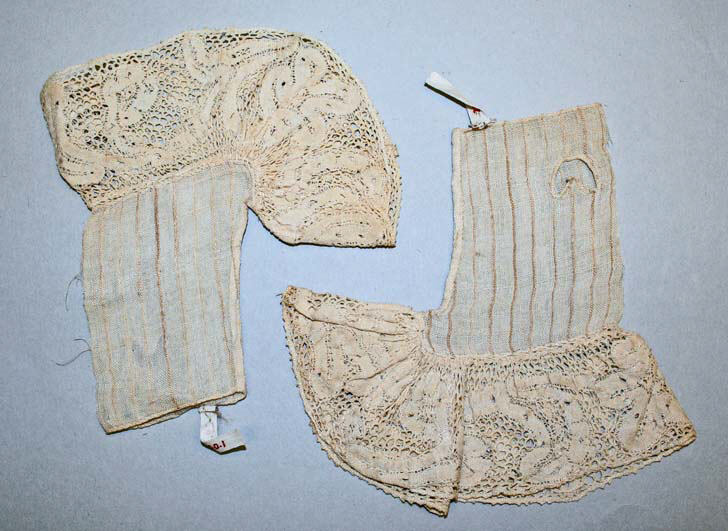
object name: christening mitt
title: Christening mitts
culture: american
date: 1801-1900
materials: cotton, linen